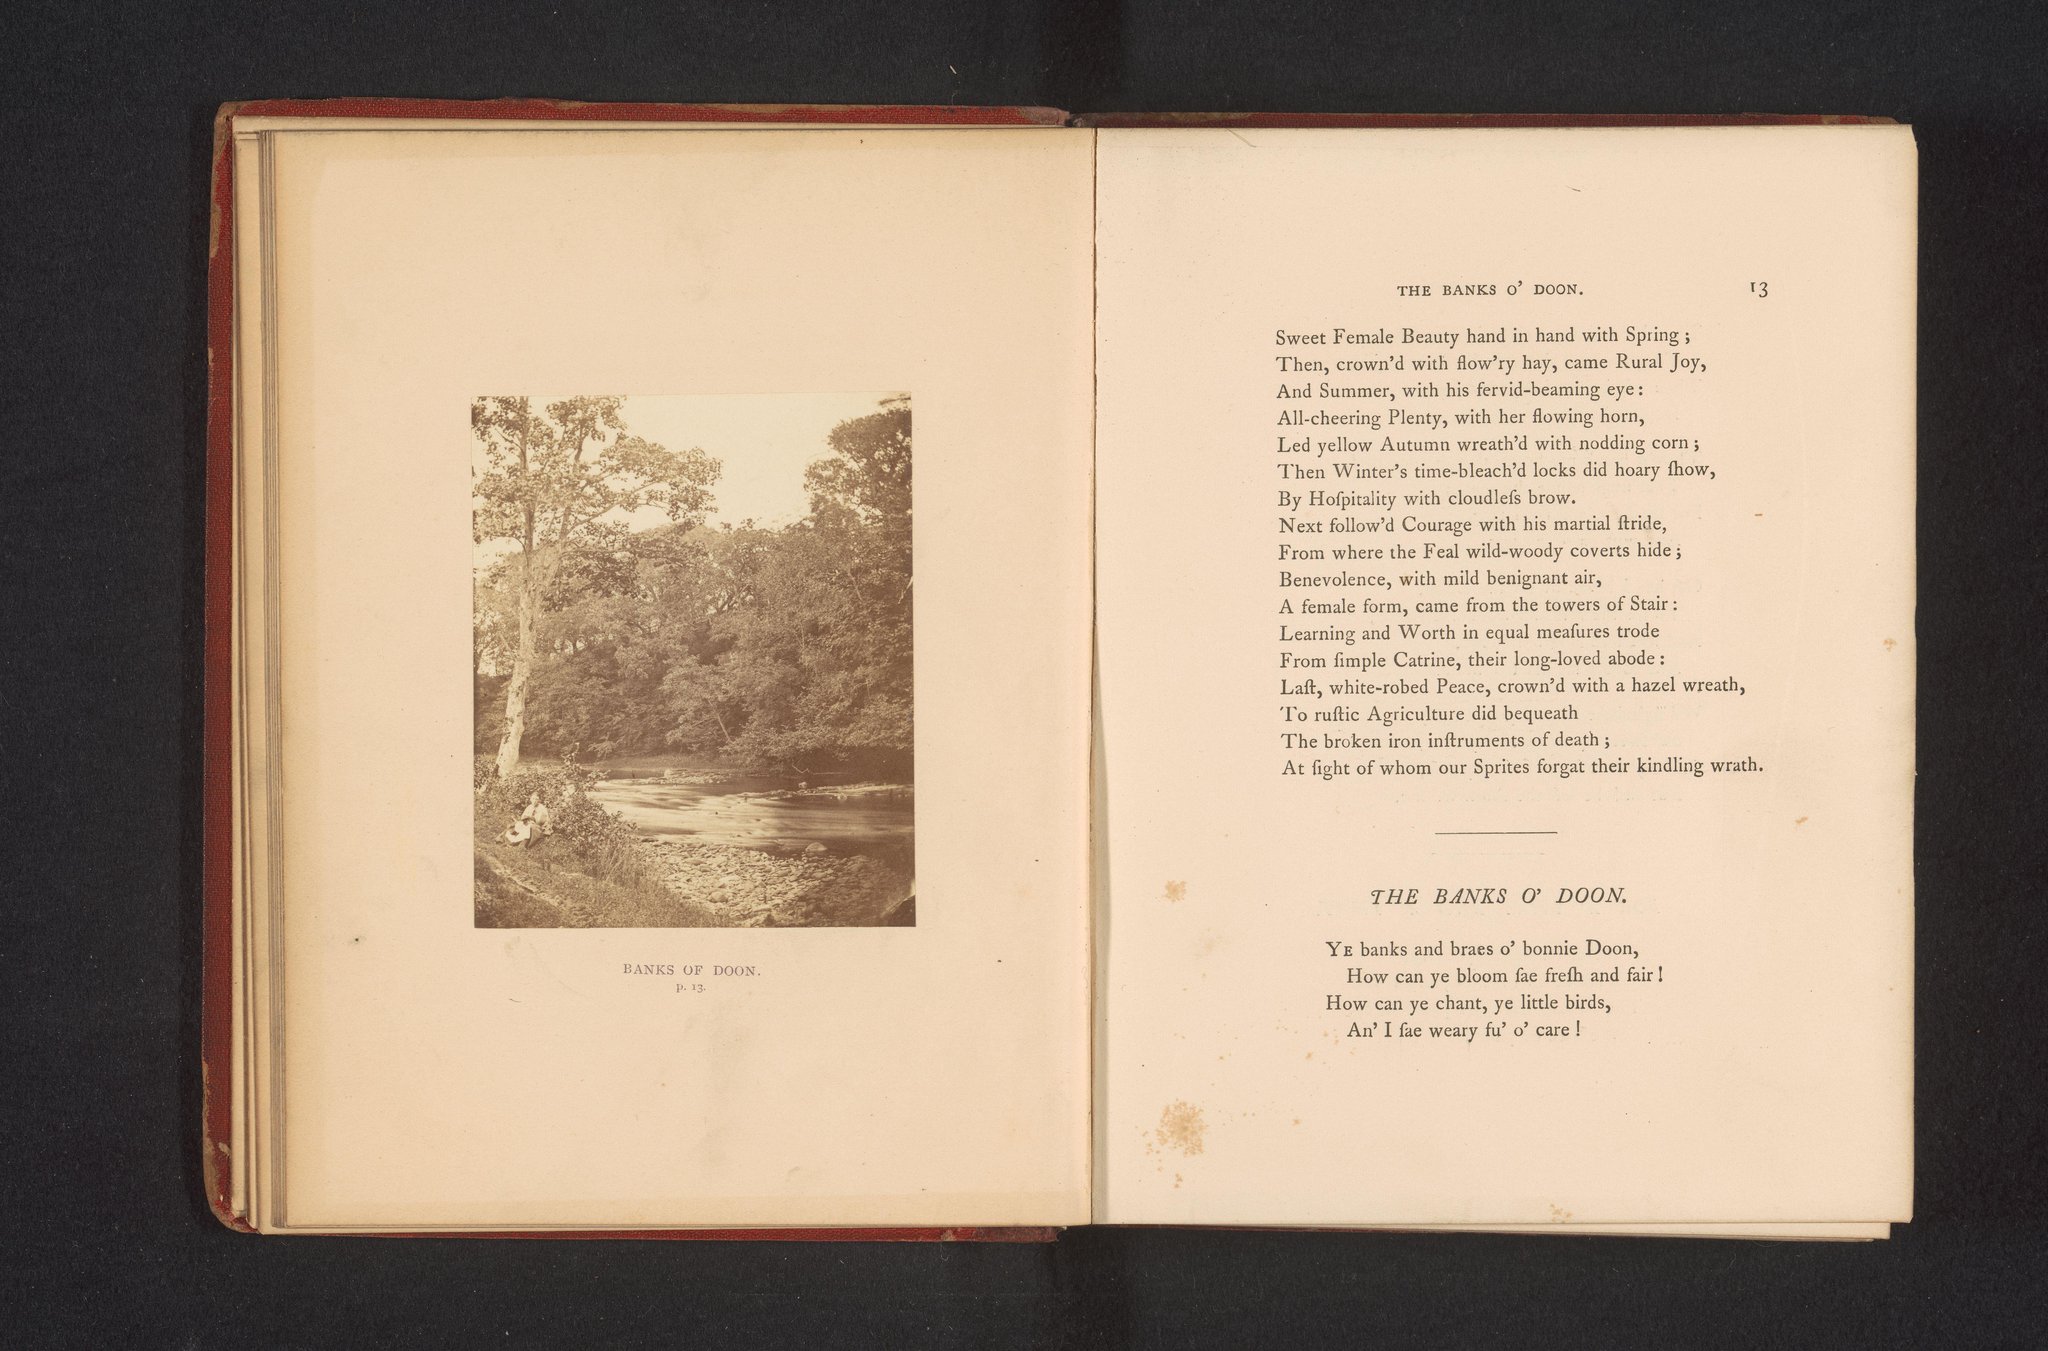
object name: page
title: Banks of Doon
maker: stephen thompson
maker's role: fotograaf, schrijver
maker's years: 1831-1893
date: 1863-1868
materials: photographic support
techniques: albumen print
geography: scotland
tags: river